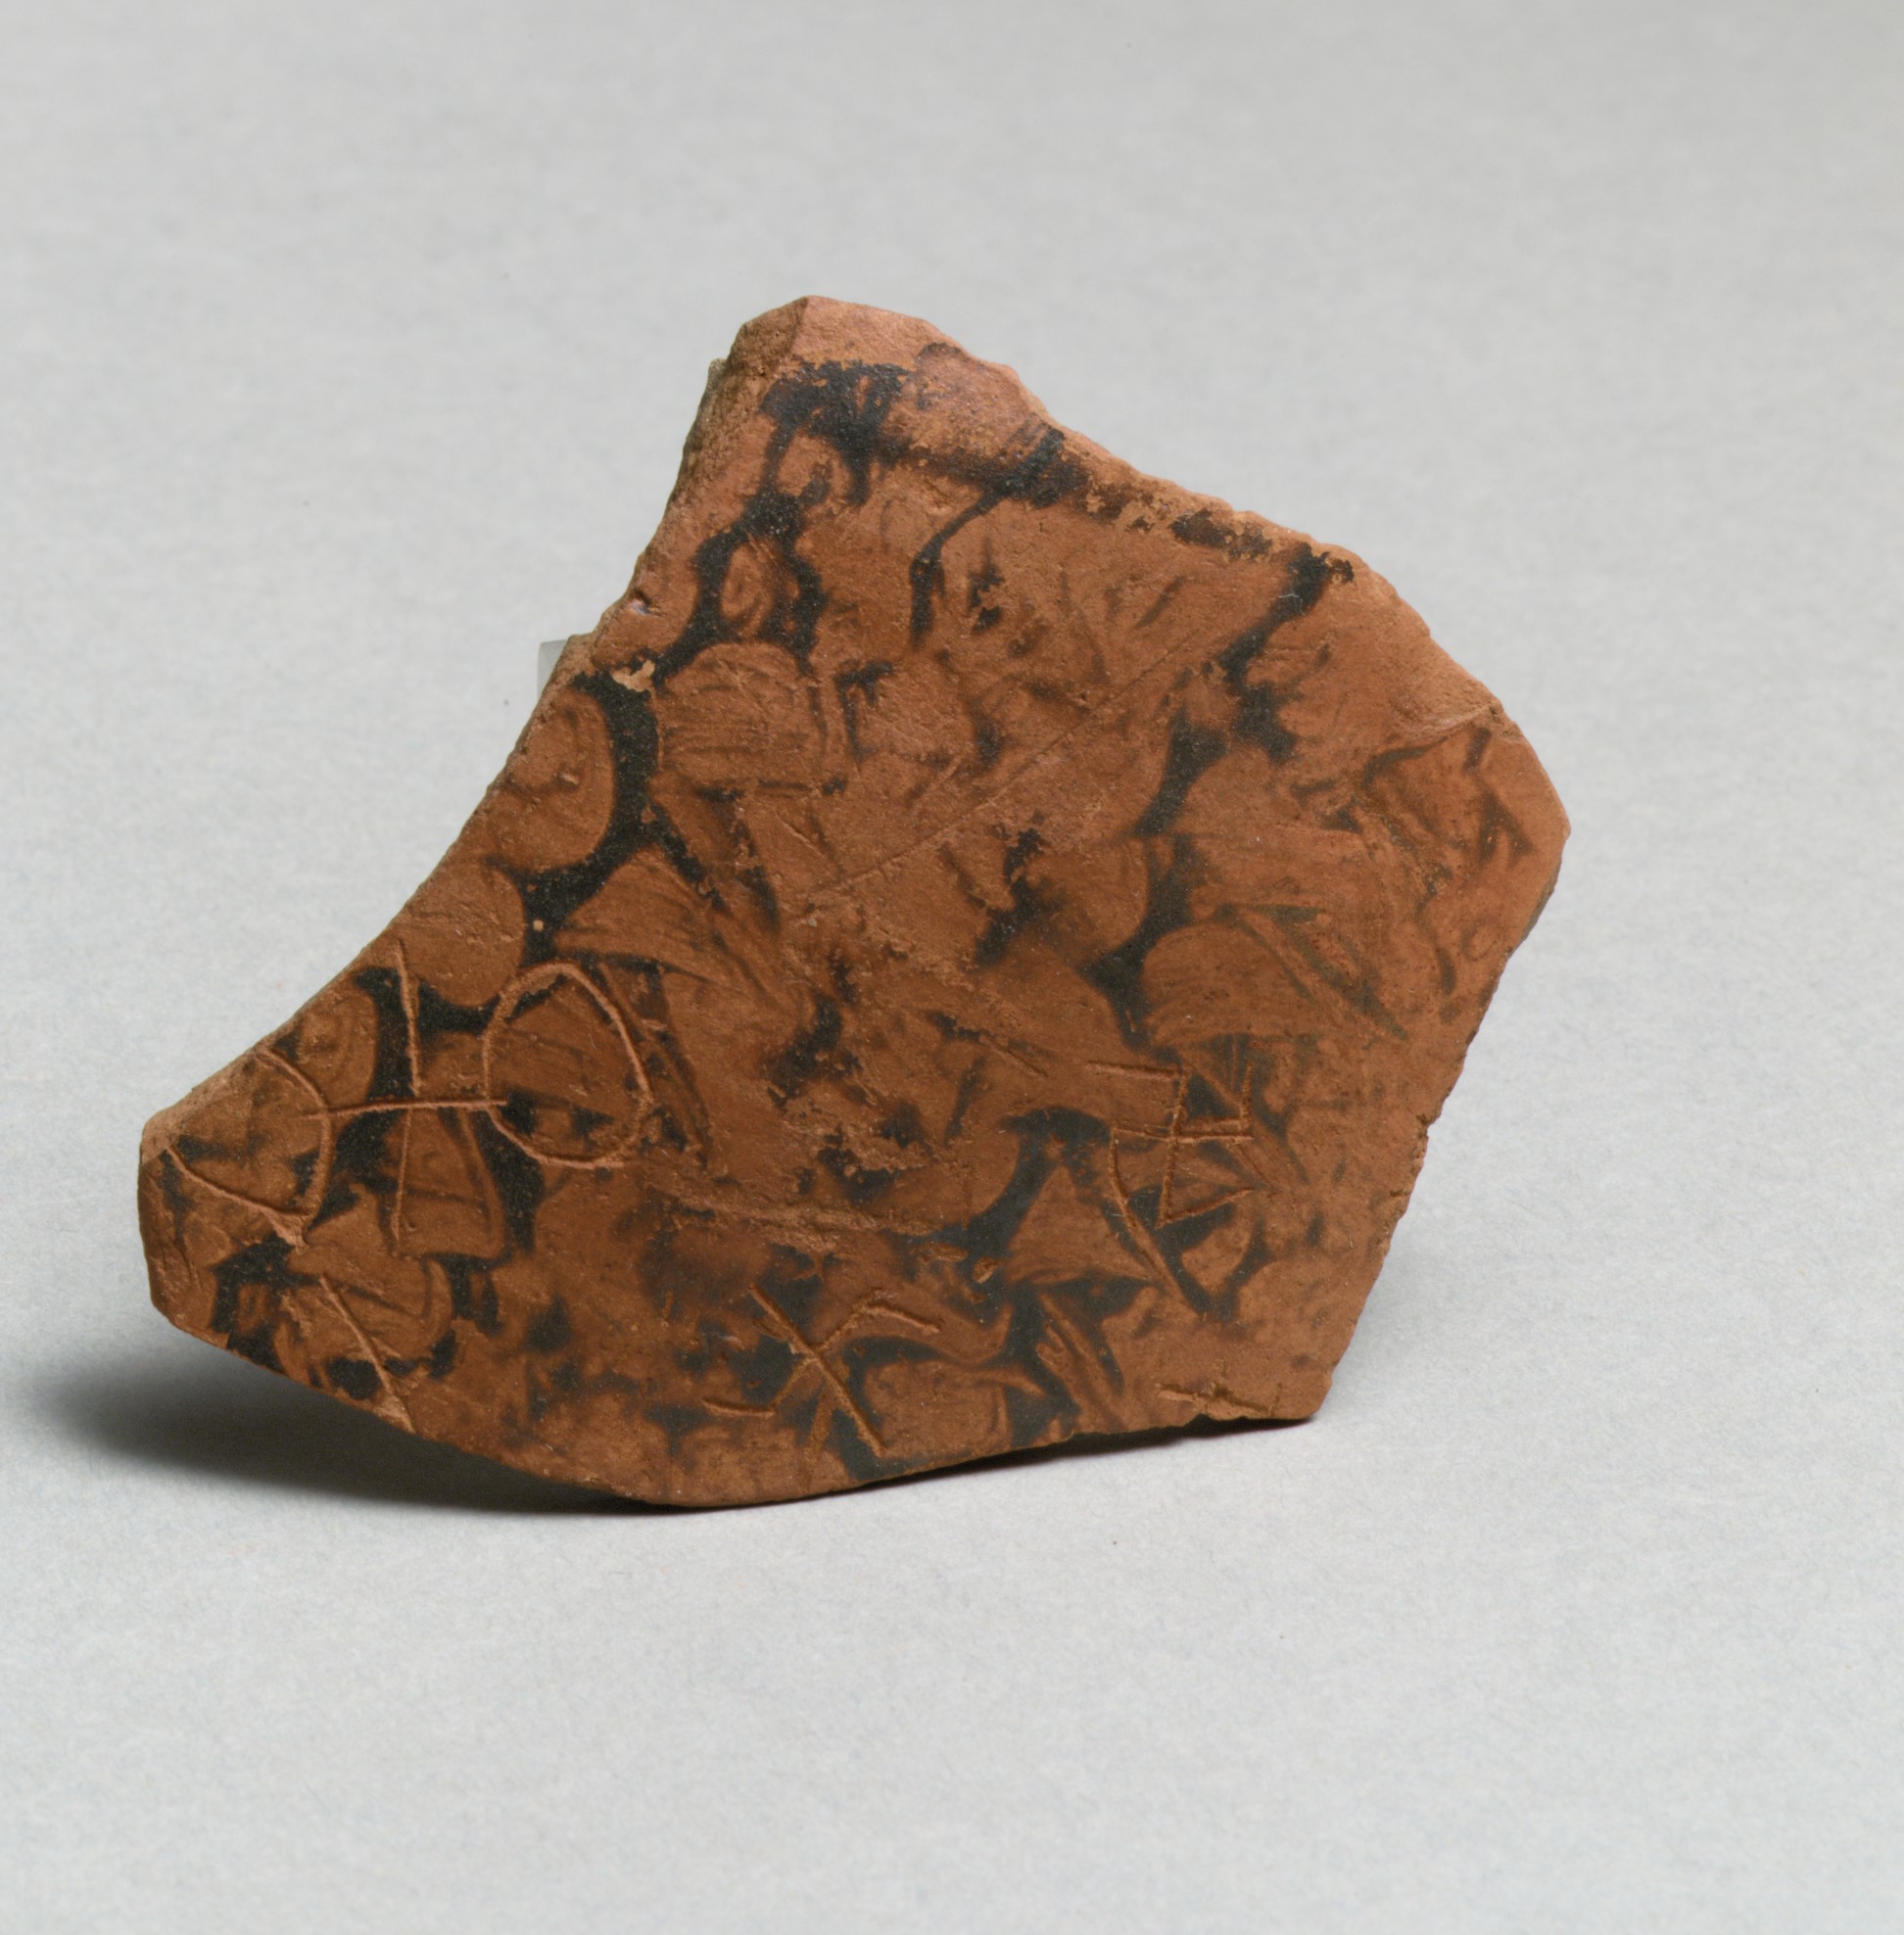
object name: vase fragment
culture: greek or lydian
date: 900-30 BCE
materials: terracotta